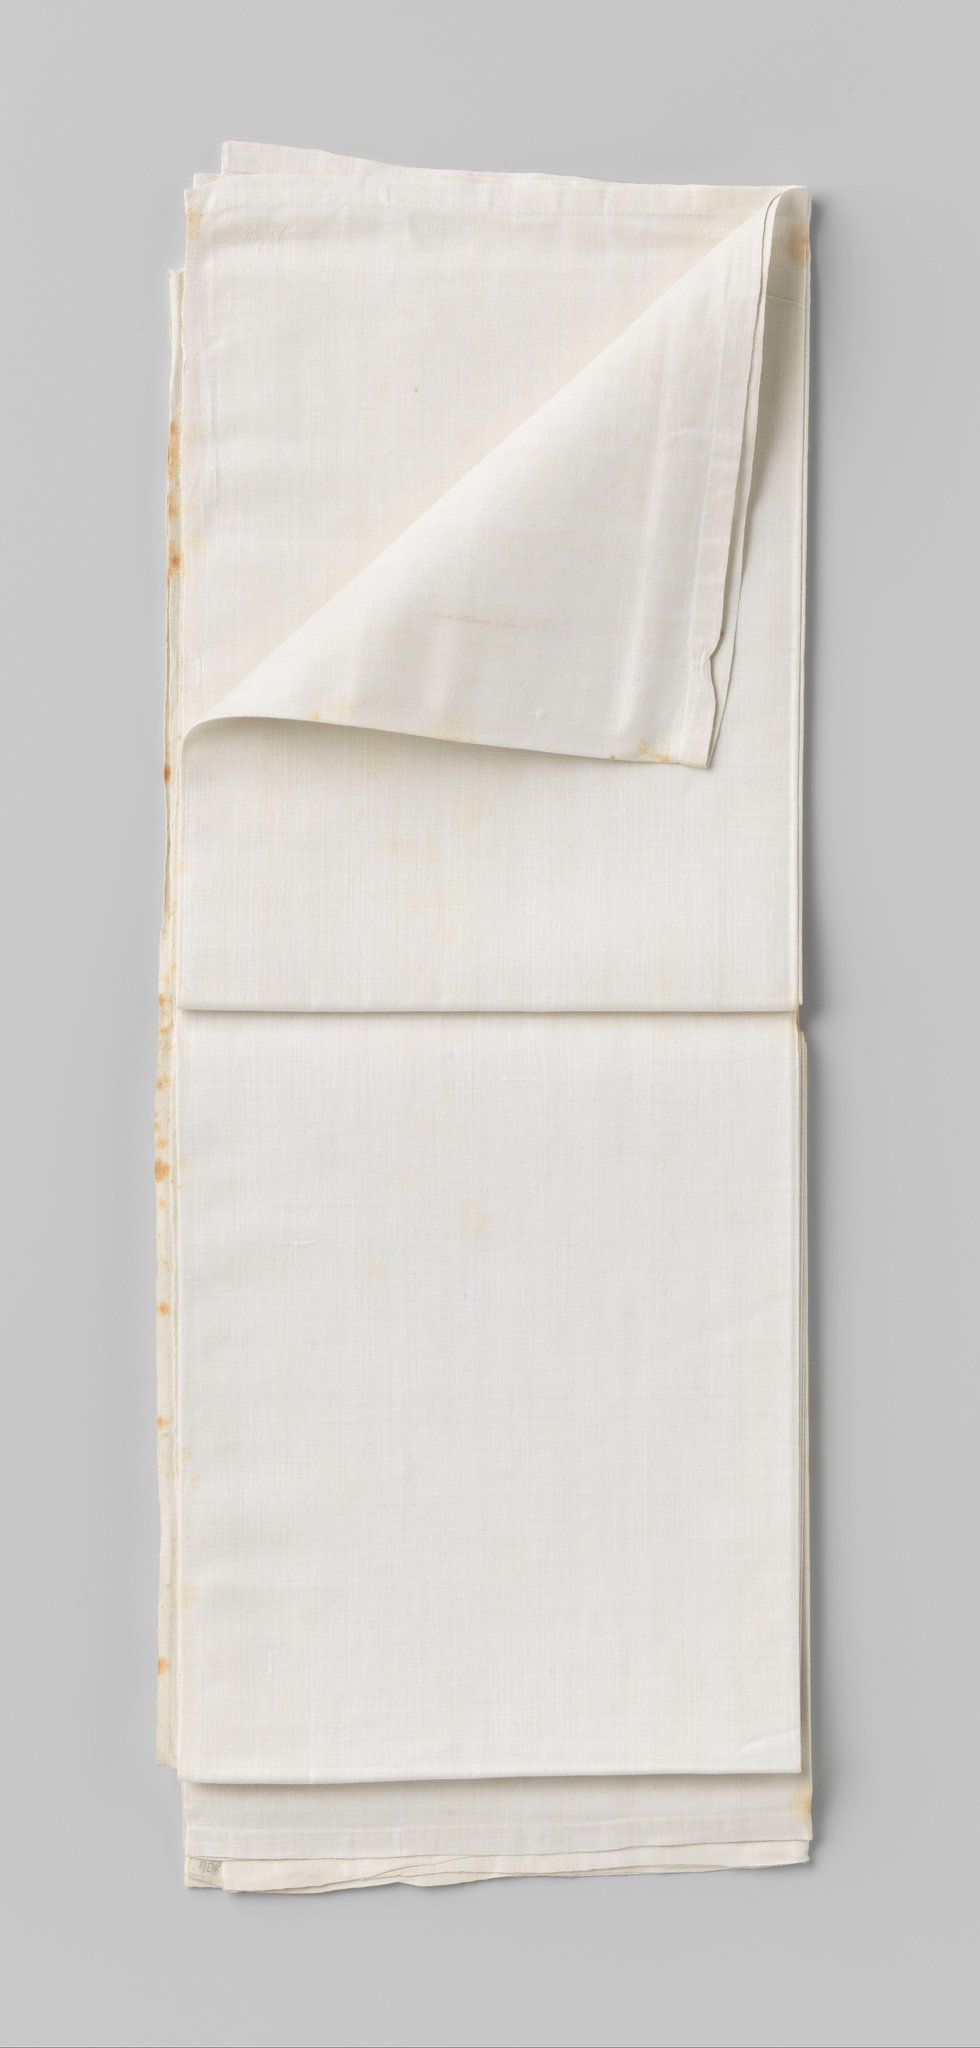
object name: beddenlaken, laken object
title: Kinderlaken. Merk: HW 18.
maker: Anonymous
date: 1852-1860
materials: linen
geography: northern netherlands